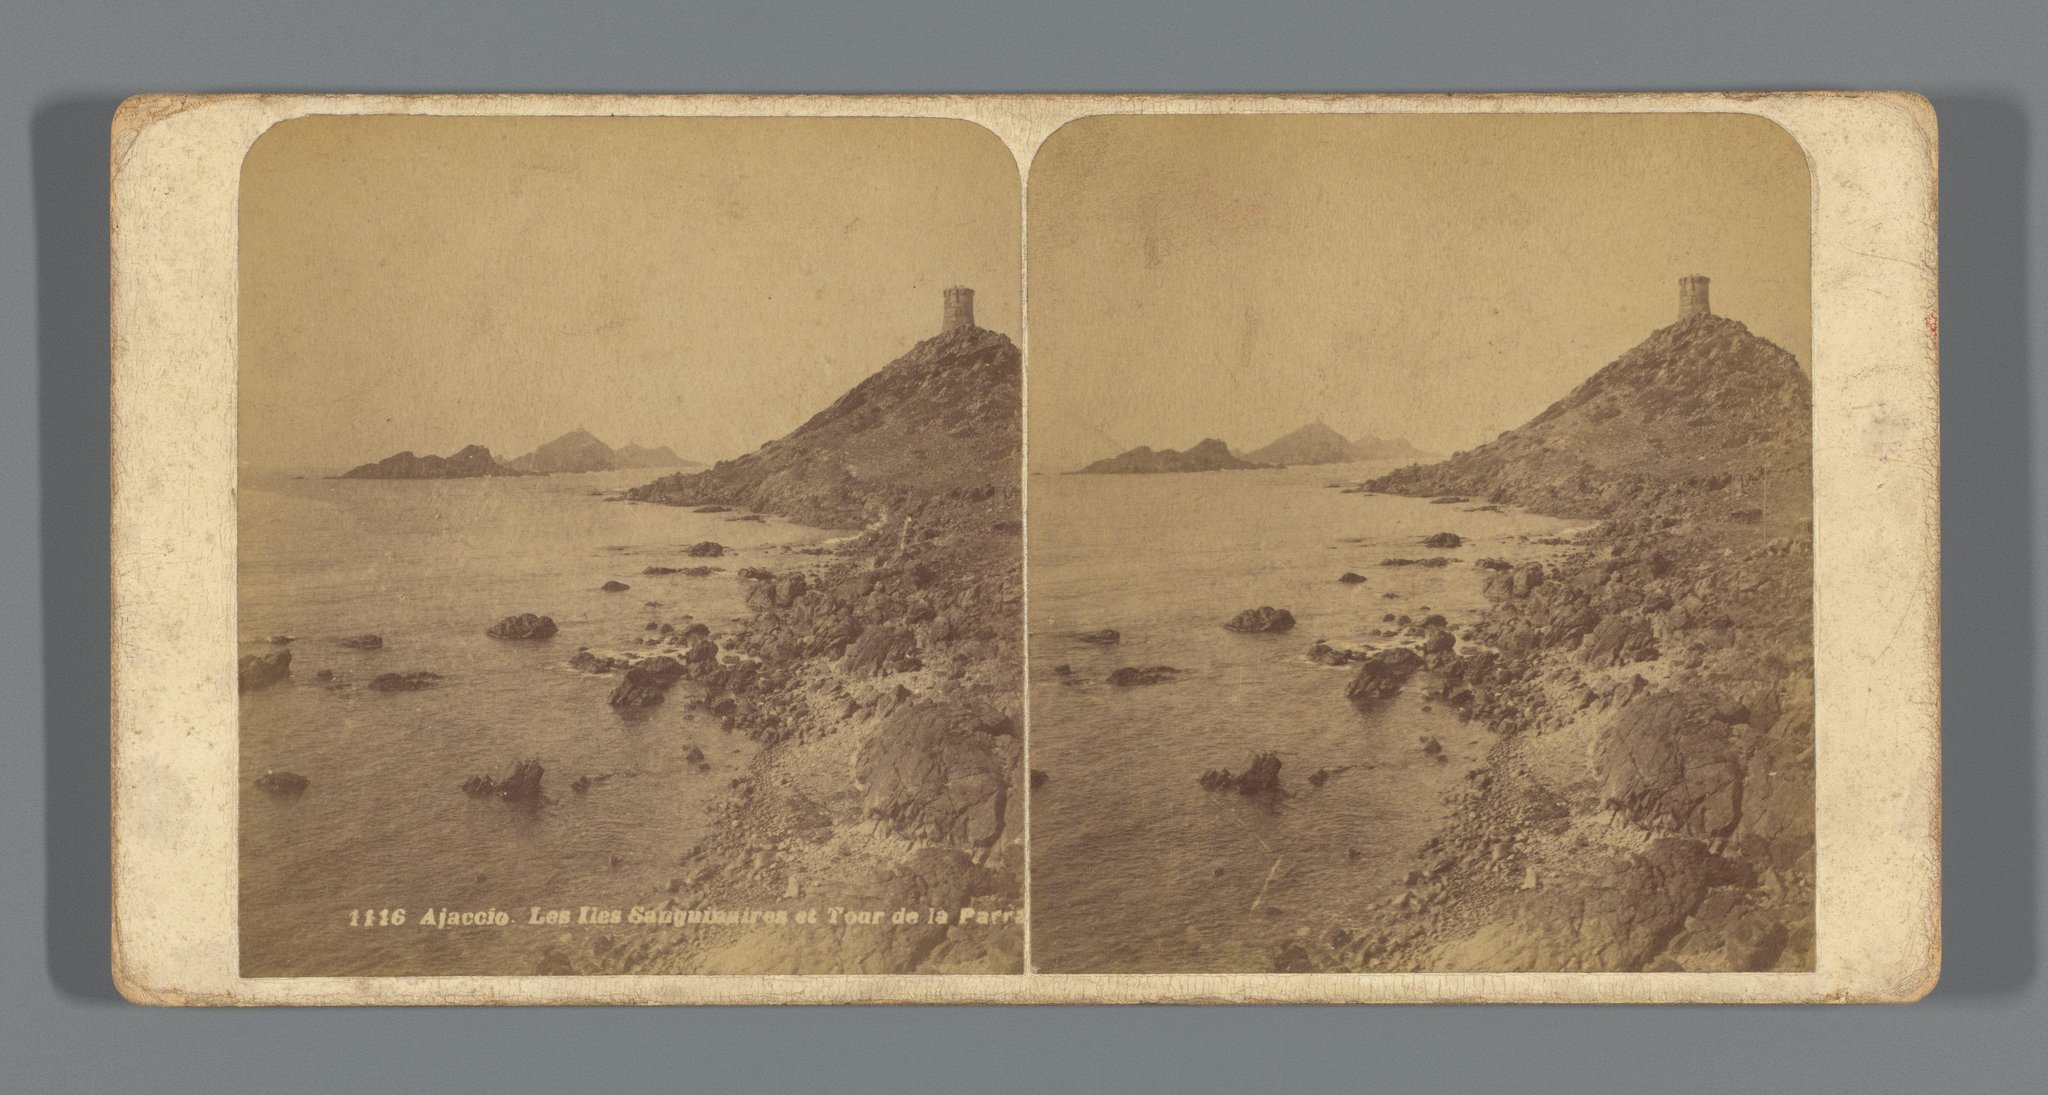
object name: stereograph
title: Aardrijkskundige Beeldengalerij, verzameld door M.J. Broekhuijsen, Hoofd eener school te Amsterdam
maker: martien johan broekhuijsen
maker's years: 1871-1956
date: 1905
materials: photographic support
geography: amsterdam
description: Onderdeel van een groep van 52 stereofoto's gebruikt in het lager onderwijs als aanvulling op schoolplaten. De gehele reeks bestond uit 274 nummers in 10 categorieën (A t/m K).